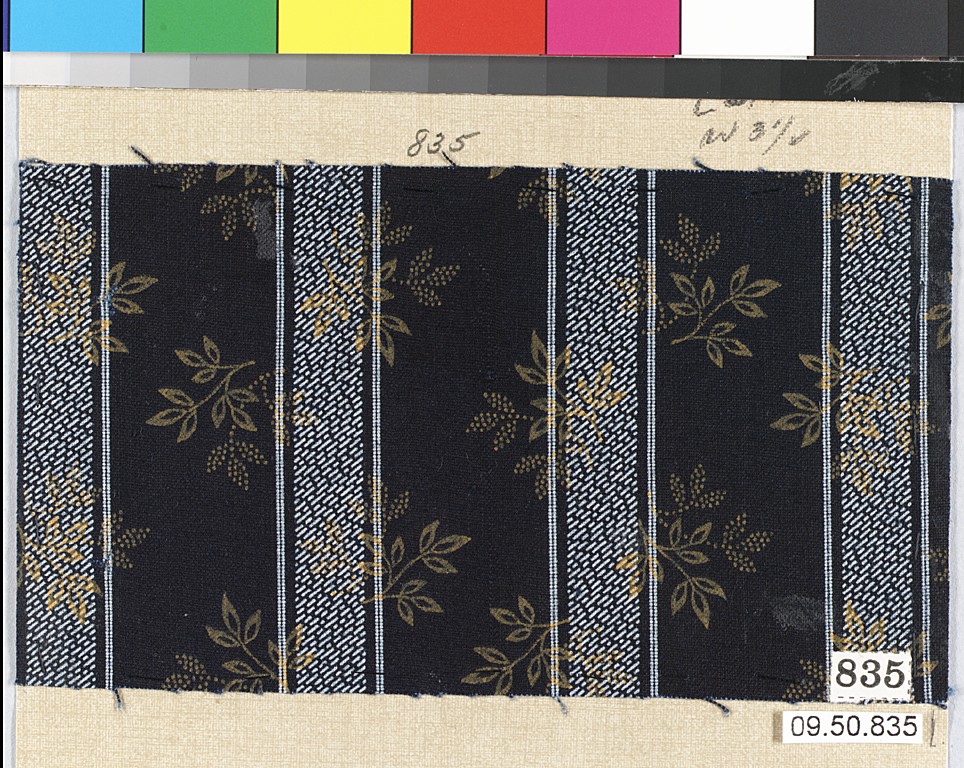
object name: piece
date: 1801-1900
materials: cotton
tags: leaves